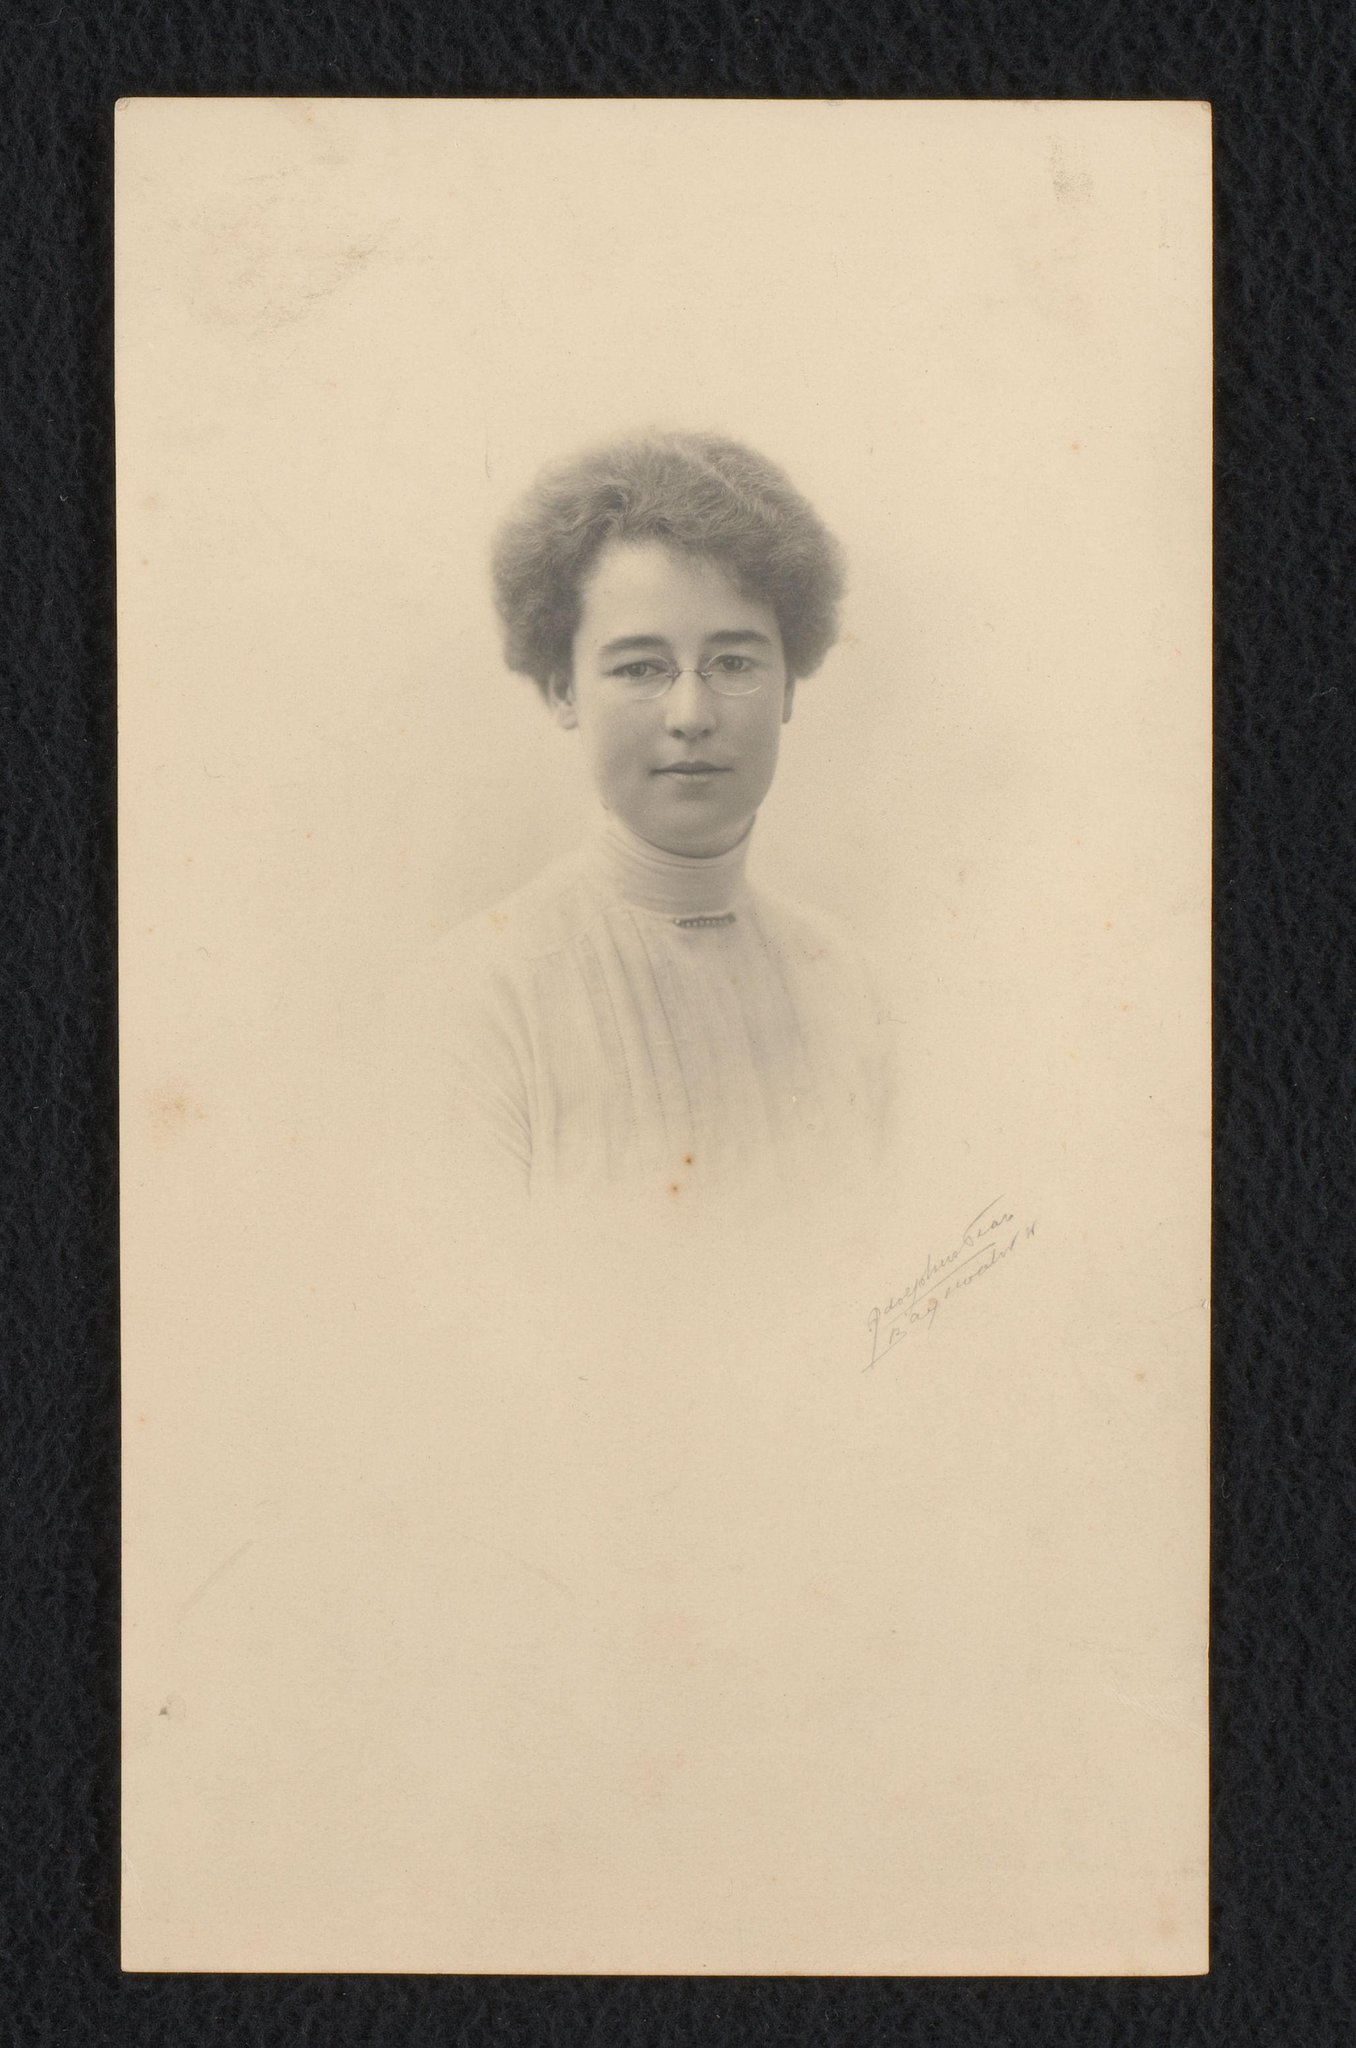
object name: photograph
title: Portret van een vrouw, mogelijk Liesbeth Overhoff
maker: adolphus tear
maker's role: fotograaf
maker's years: 1862-1925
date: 1910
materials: paper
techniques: matte daylight collodion silver print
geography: london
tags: liesbeth overhoff, historical persons - bb - woman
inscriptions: inscription: ‘ADOLPHUS TEAR,/ 42 High Street,/ Notting HIll Gate,/ LONDON, W.11./ Phone: Park 751.’, number: ‘47060 1’, address: ‘Adolphus Tear/ Bayswater W.’